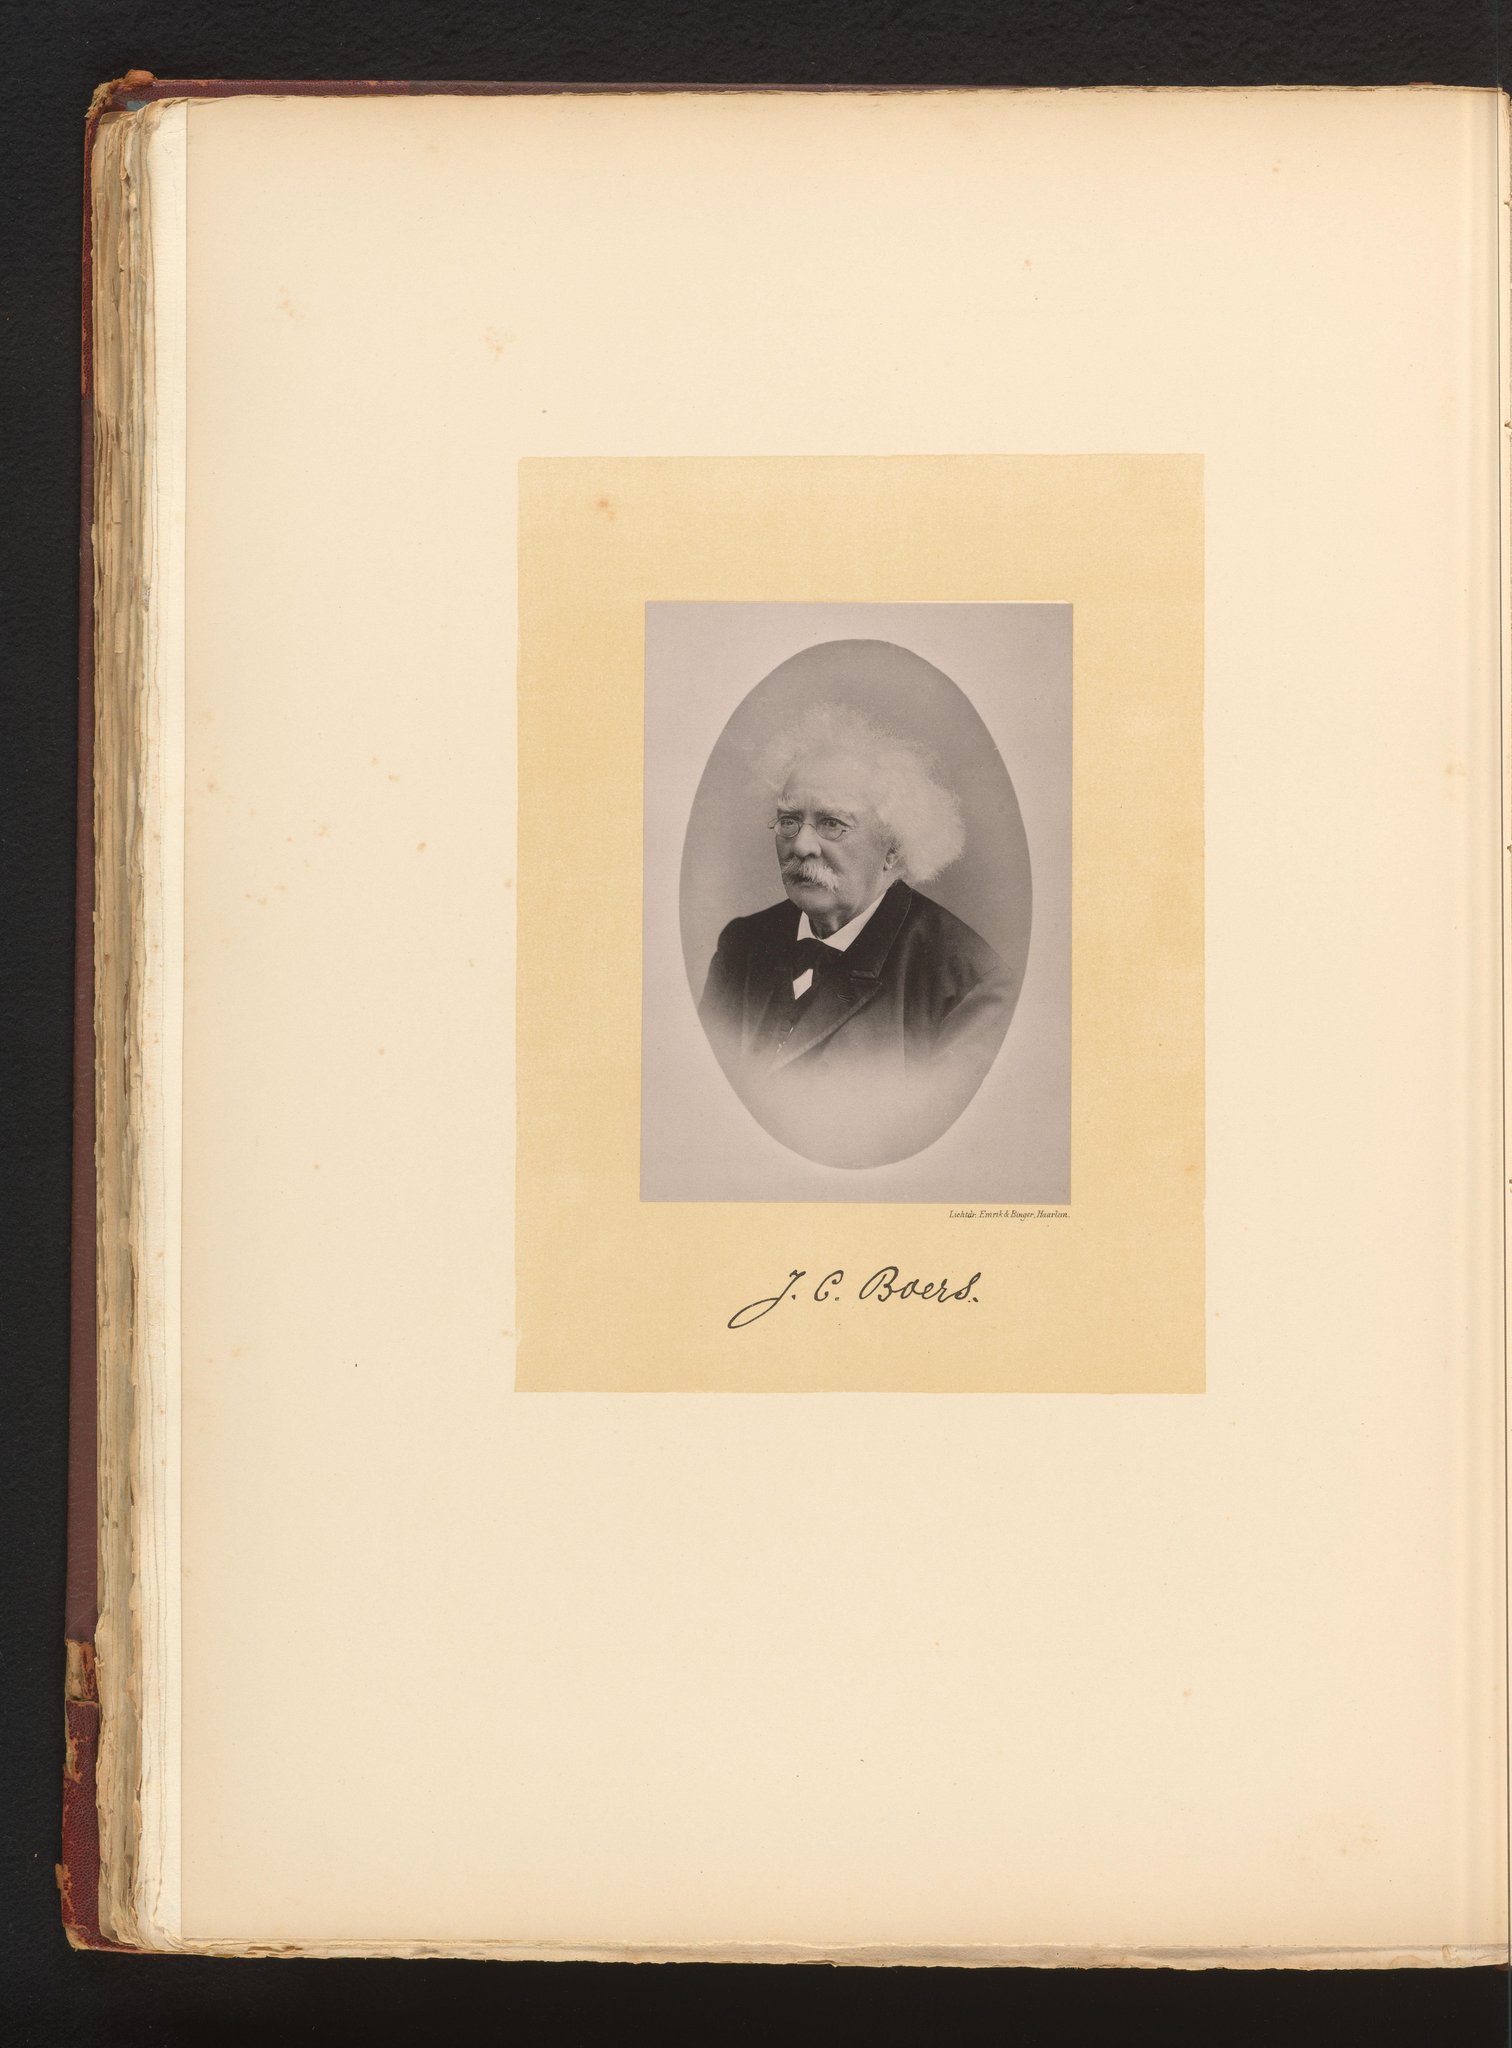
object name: page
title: J.G. Boers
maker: Anonymous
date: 1888-1896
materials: paper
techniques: photograph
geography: haarlem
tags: nijmegen, delft, historical persons, portrait of a musician